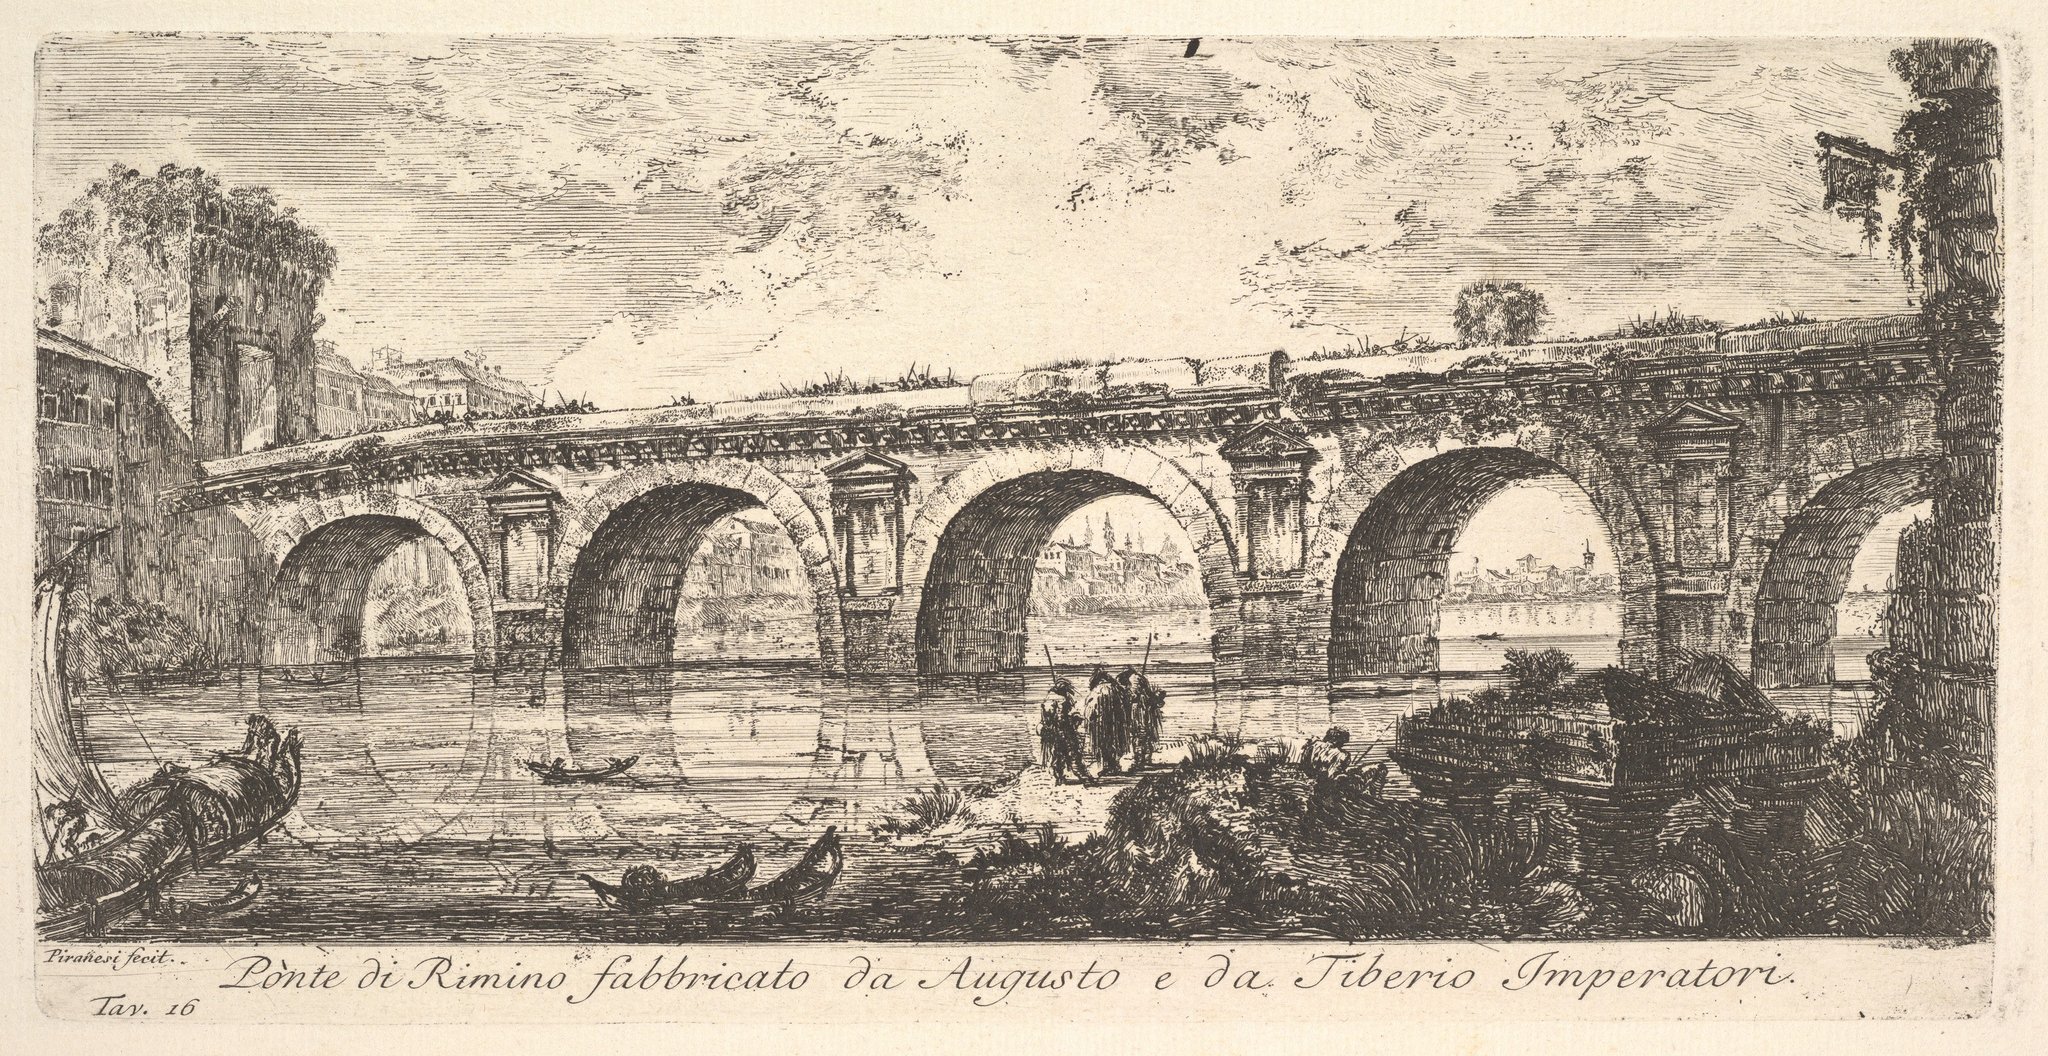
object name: print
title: Plate 16: The Bridge at Rimini built by the Emperors Augustus and Tiberius (Ponte di Rimino fabbricato da Augusto e da Tiberio Imperatori), from "Antichità Romane fuori di Roma"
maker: giovanni battista piranesi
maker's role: artist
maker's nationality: italian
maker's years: 1720-1778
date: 1748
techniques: etching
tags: bridges,rivers